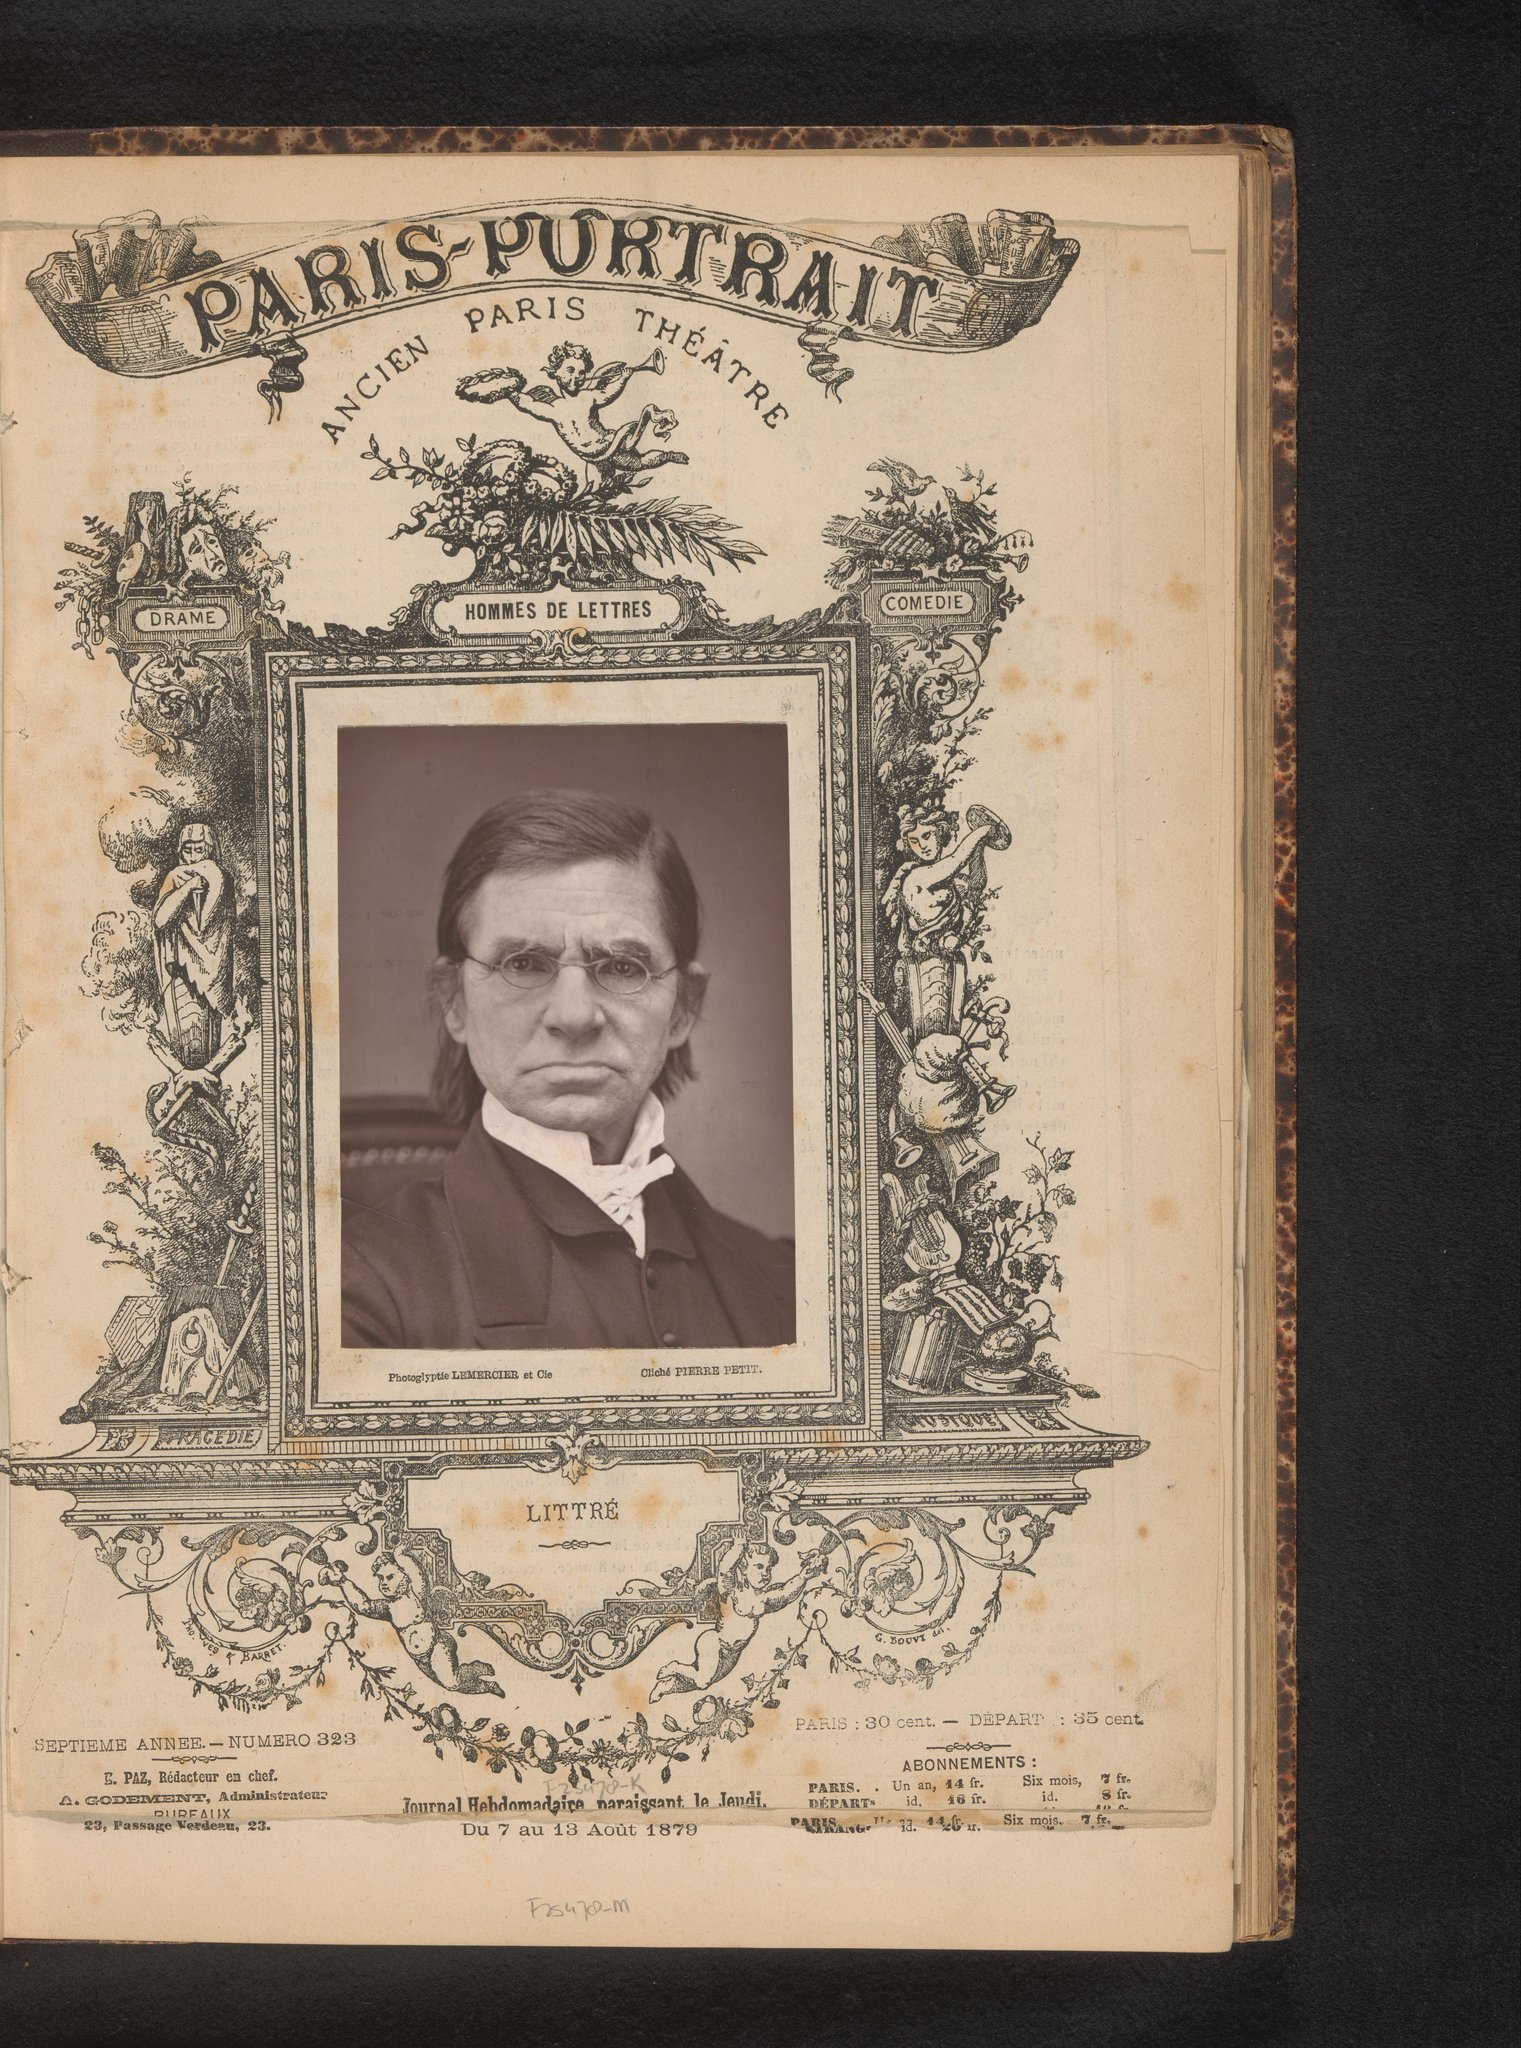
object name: photomechanical print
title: Littre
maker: pierre petit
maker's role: fotograaf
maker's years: 1832-1909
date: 1873-1880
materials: paper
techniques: woodburytype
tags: paris, historical persons